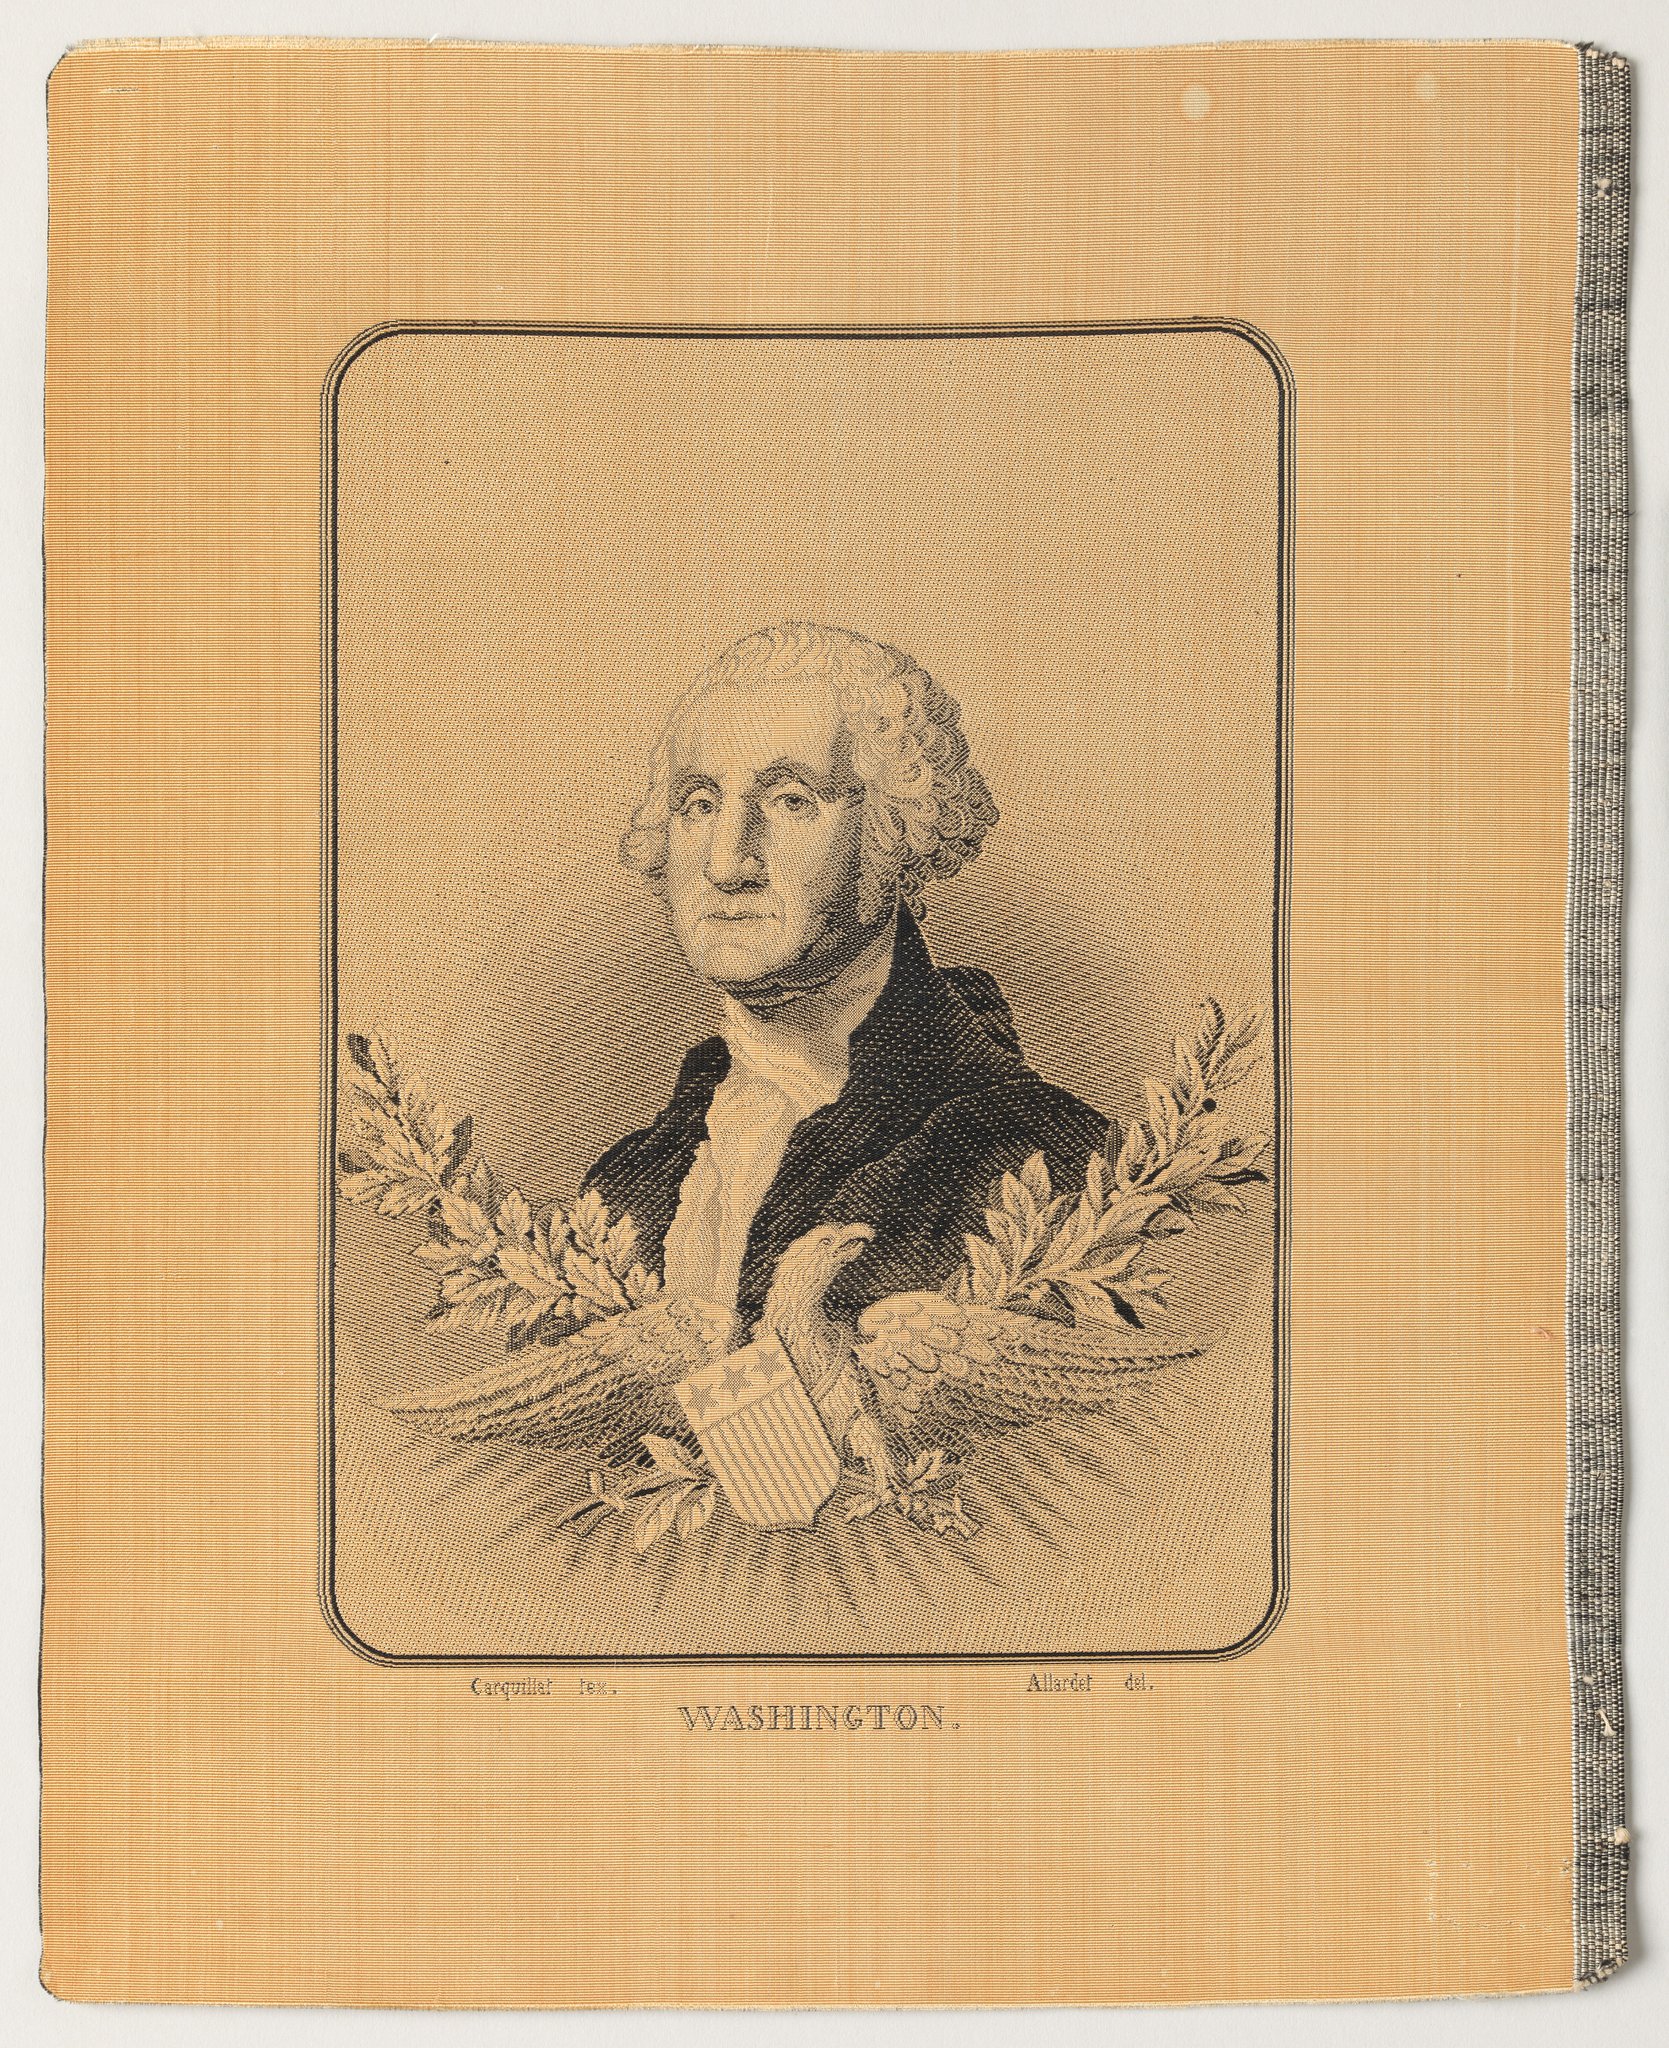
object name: portrait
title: George Washington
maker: jacques allardet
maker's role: designer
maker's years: 1800-1900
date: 1865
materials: silk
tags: birds,george washington,portraits,coat of arms